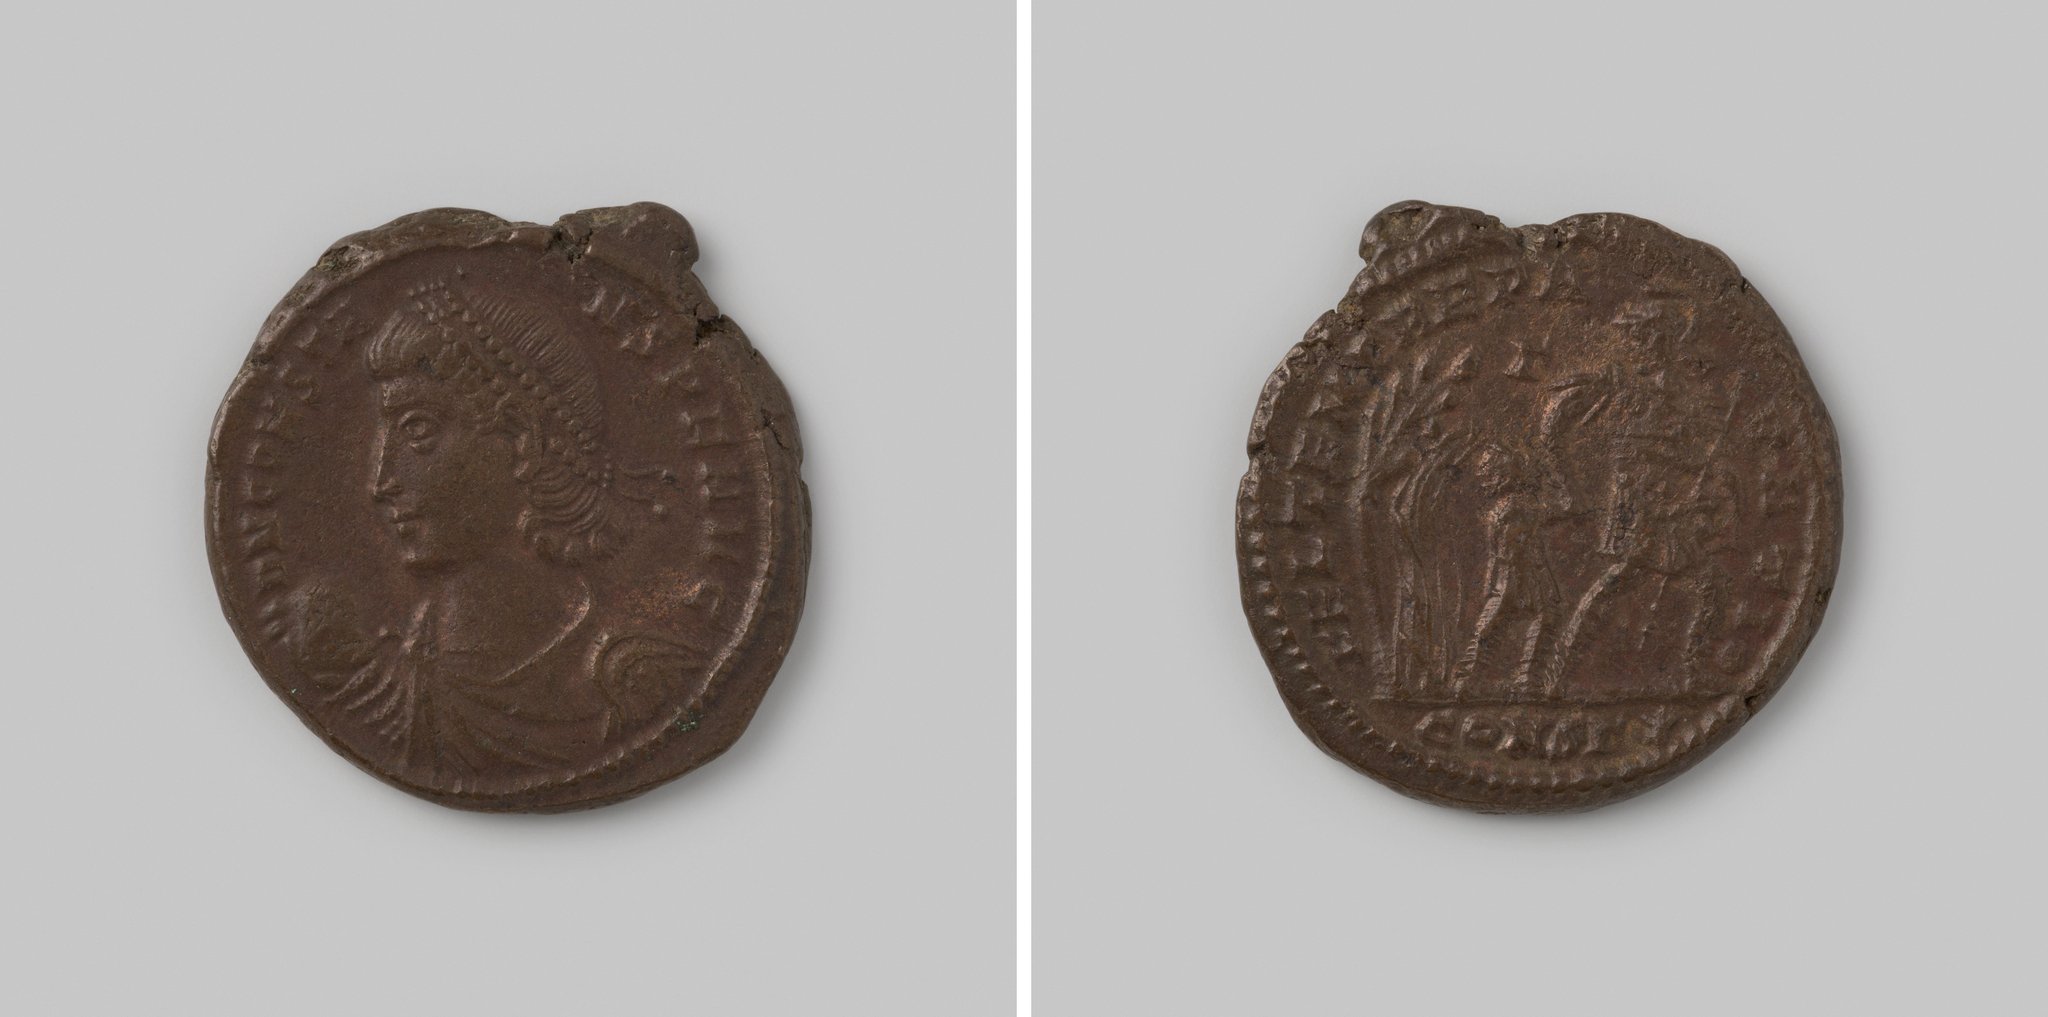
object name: ae2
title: Midden brons uit het Romeinse Keizerrijk van Constans I, 337-350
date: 337-350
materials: bronze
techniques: striking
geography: constantinople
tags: constans i (keizer van het romeinse rijk)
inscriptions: circumscription: ‘FEL TEMP REPA - RATIO’, circumscription: ‘D N CONSTA - NS P F AVG’, inscription: ‘CONSΓ* / Γ’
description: keerzijde: soldaat lopend naar rechts, die een kind links van hem uit een hut onder een boom meevoert, in linkerhand een speer, tekst in afsnede en op veld